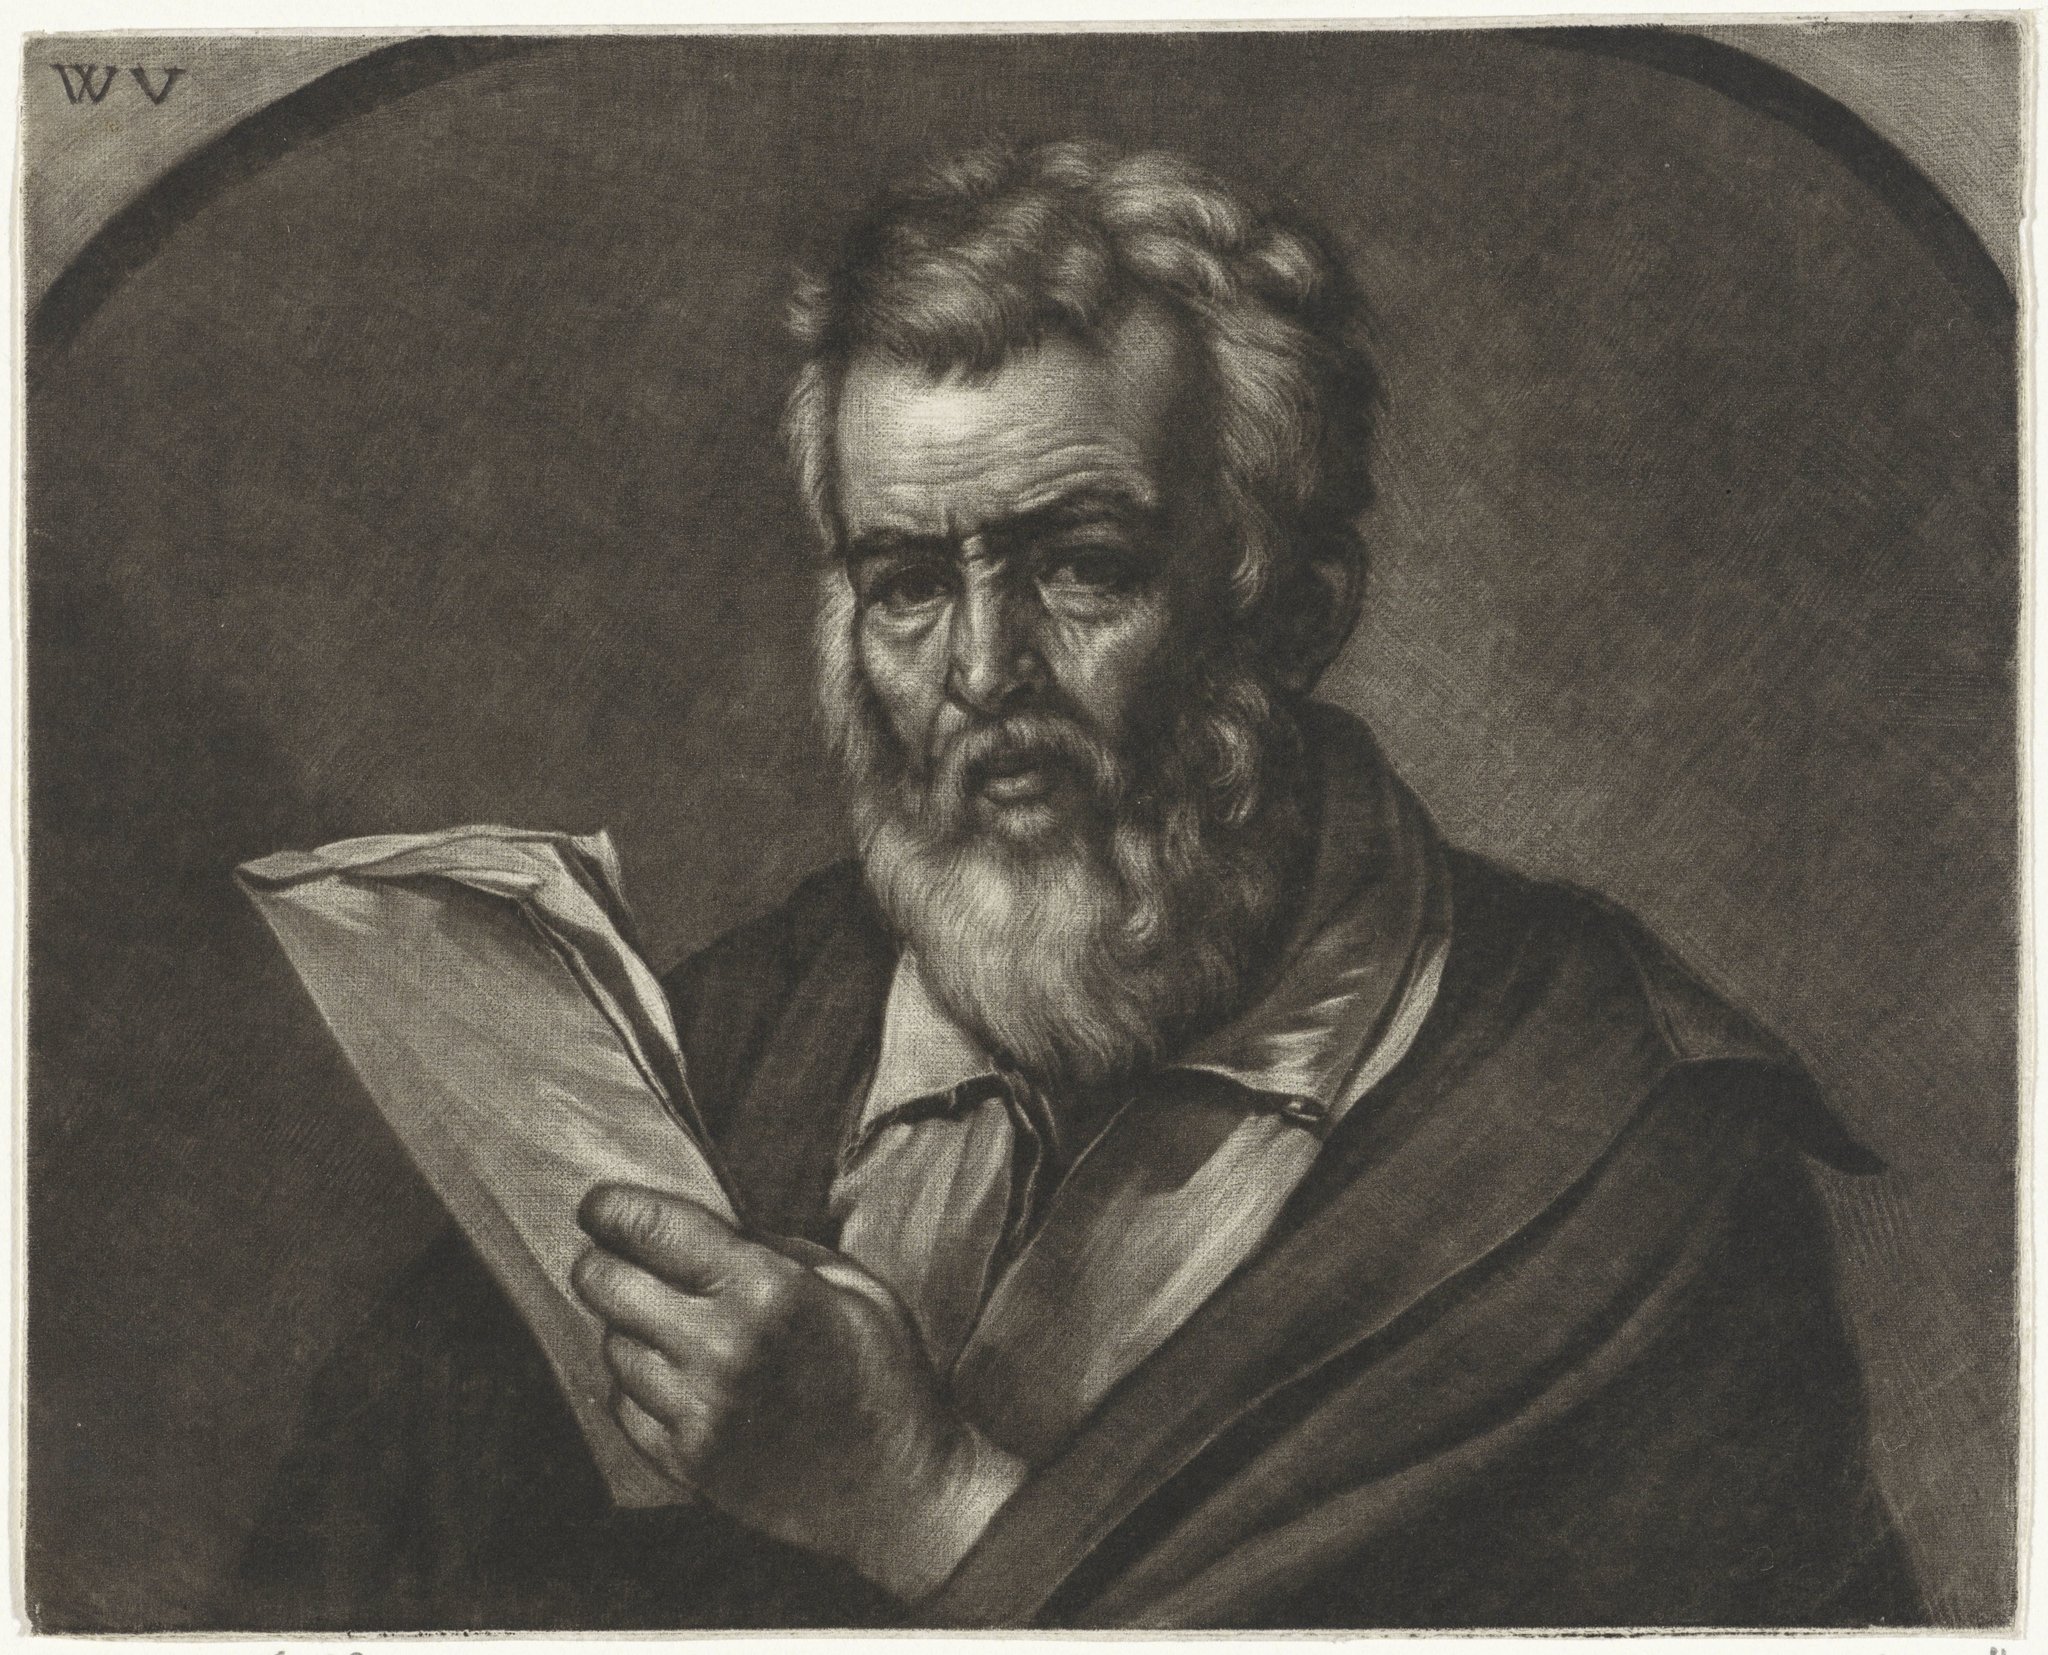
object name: print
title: Man met een boekje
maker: wallerant vaillant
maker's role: draughtsman, painter, print maker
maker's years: 1623-1677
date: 1658-1677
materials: paper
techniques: mezzotint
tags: book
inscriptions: collector's mark: Lugt 2228